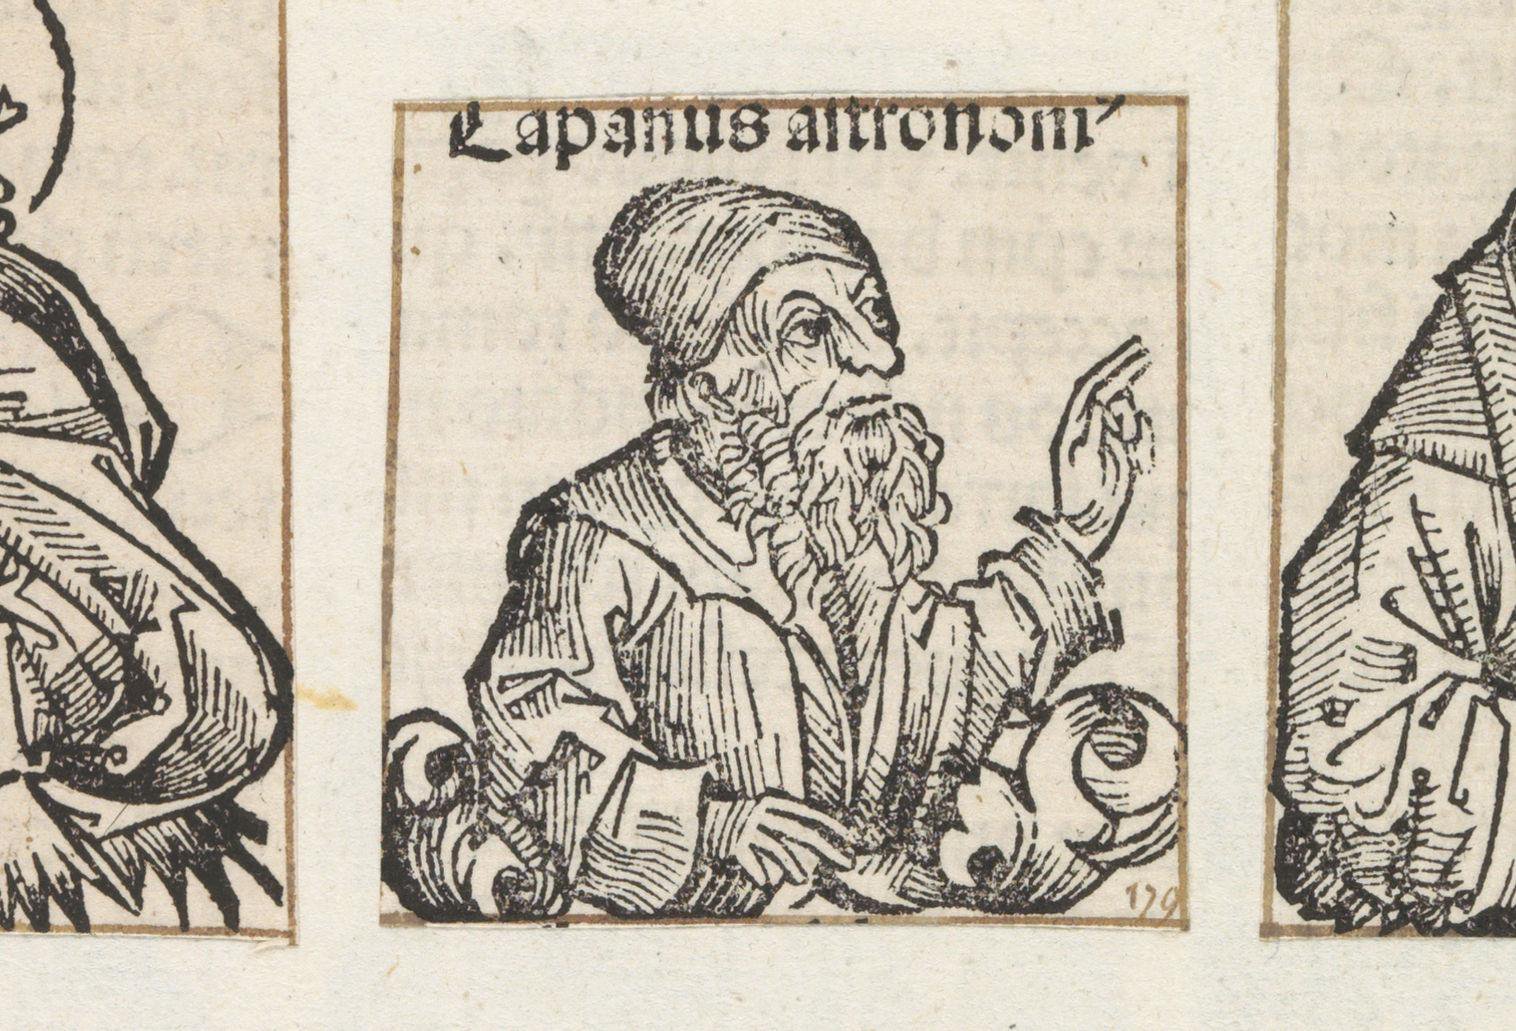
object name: album leaf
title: Campanus astronom[us]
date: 1493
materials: paper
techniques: letterpress printing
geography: nuremberg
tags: wiskundige, arts, campanus van novara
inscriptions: inscription: ‘179’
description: De houtsnede wordt herhaaldelijk gebruikt als boekillustratie in de Liber Chronicarum (of Neurenbergkroniek) van Hartmann Schedel, verschenen in het Latijn en Duits in 1493. Zie de Latijnse uitgave, folio 189v.